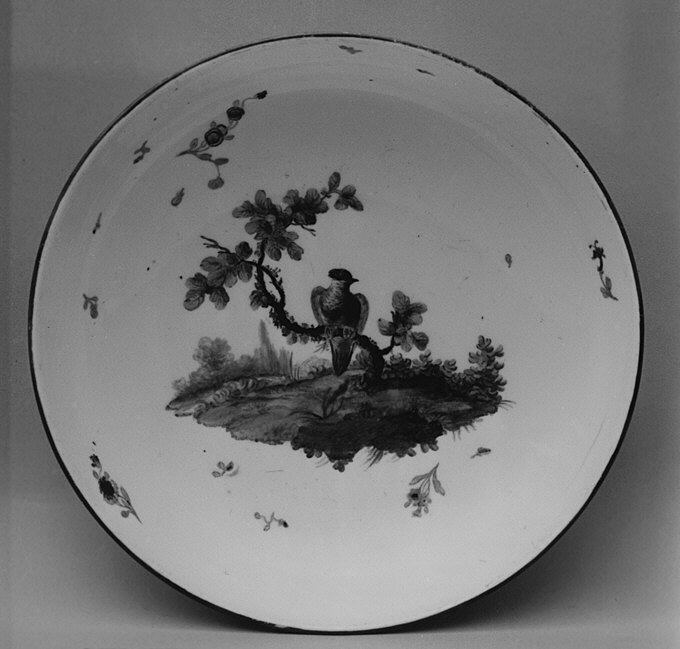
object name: saucer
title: Saucer (part of a service)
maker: frankenthal porcelain manufactory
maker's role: manufactory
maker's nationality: german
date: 1770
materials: hard paste porcelain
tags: birds,trees